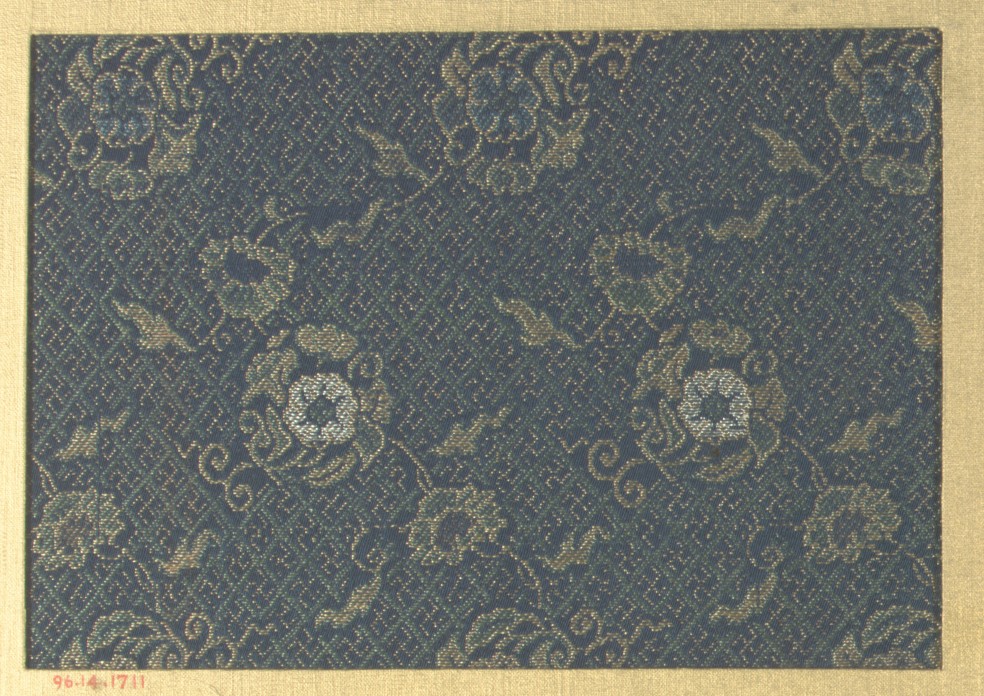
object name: piece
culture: japanese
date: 1701-1900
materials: silk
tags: flowers